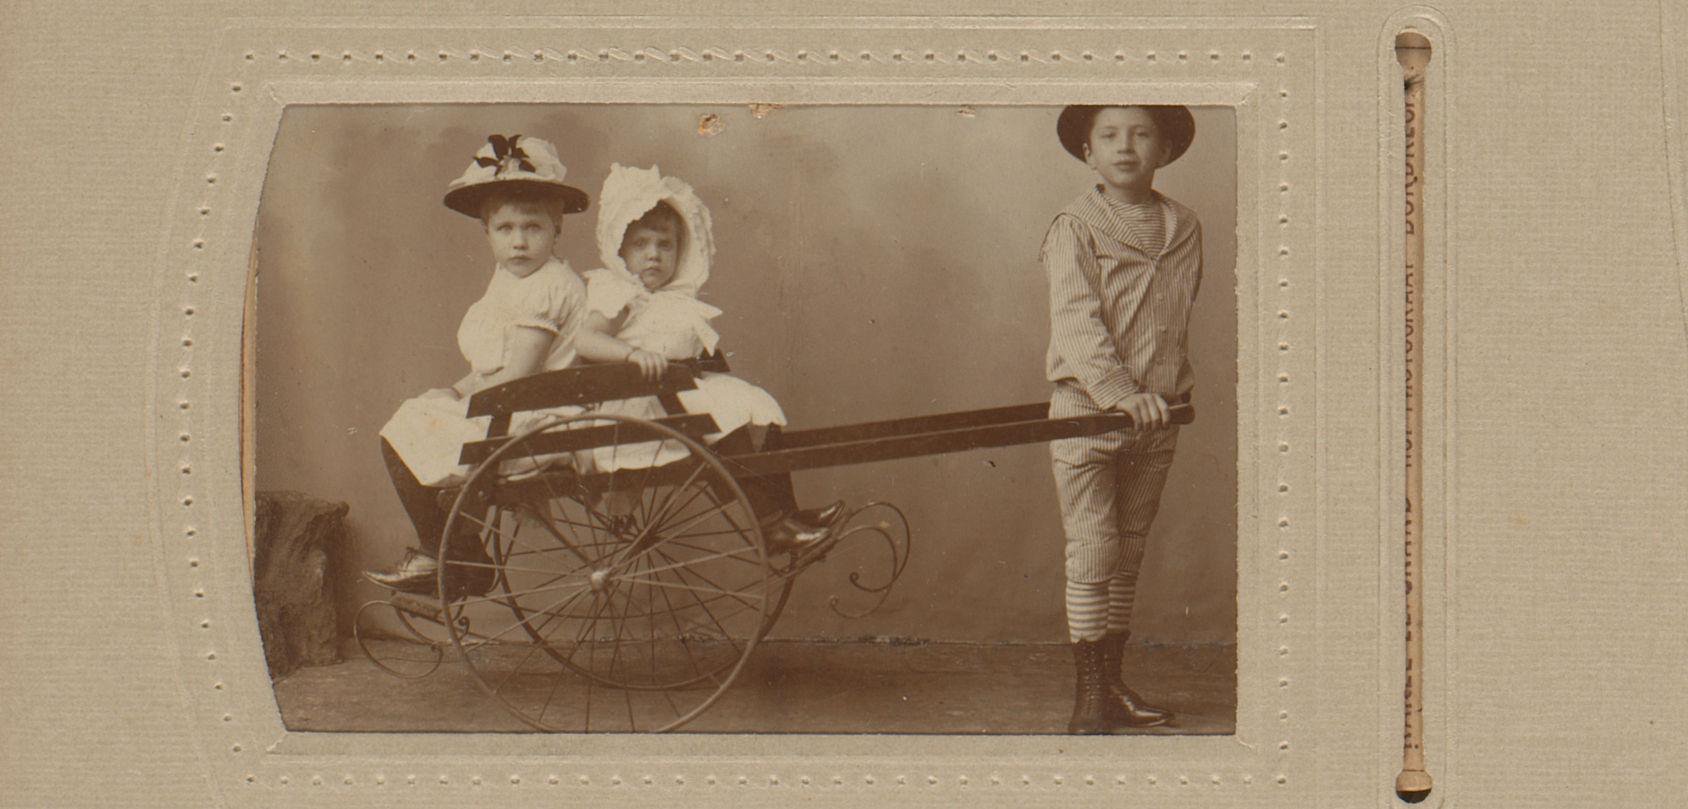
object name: photograph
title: Studioportret van twee meisjes en een jongen met een kar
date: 1900-1920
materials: paper, photographic support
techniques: gelatin silver print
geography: dordrecht